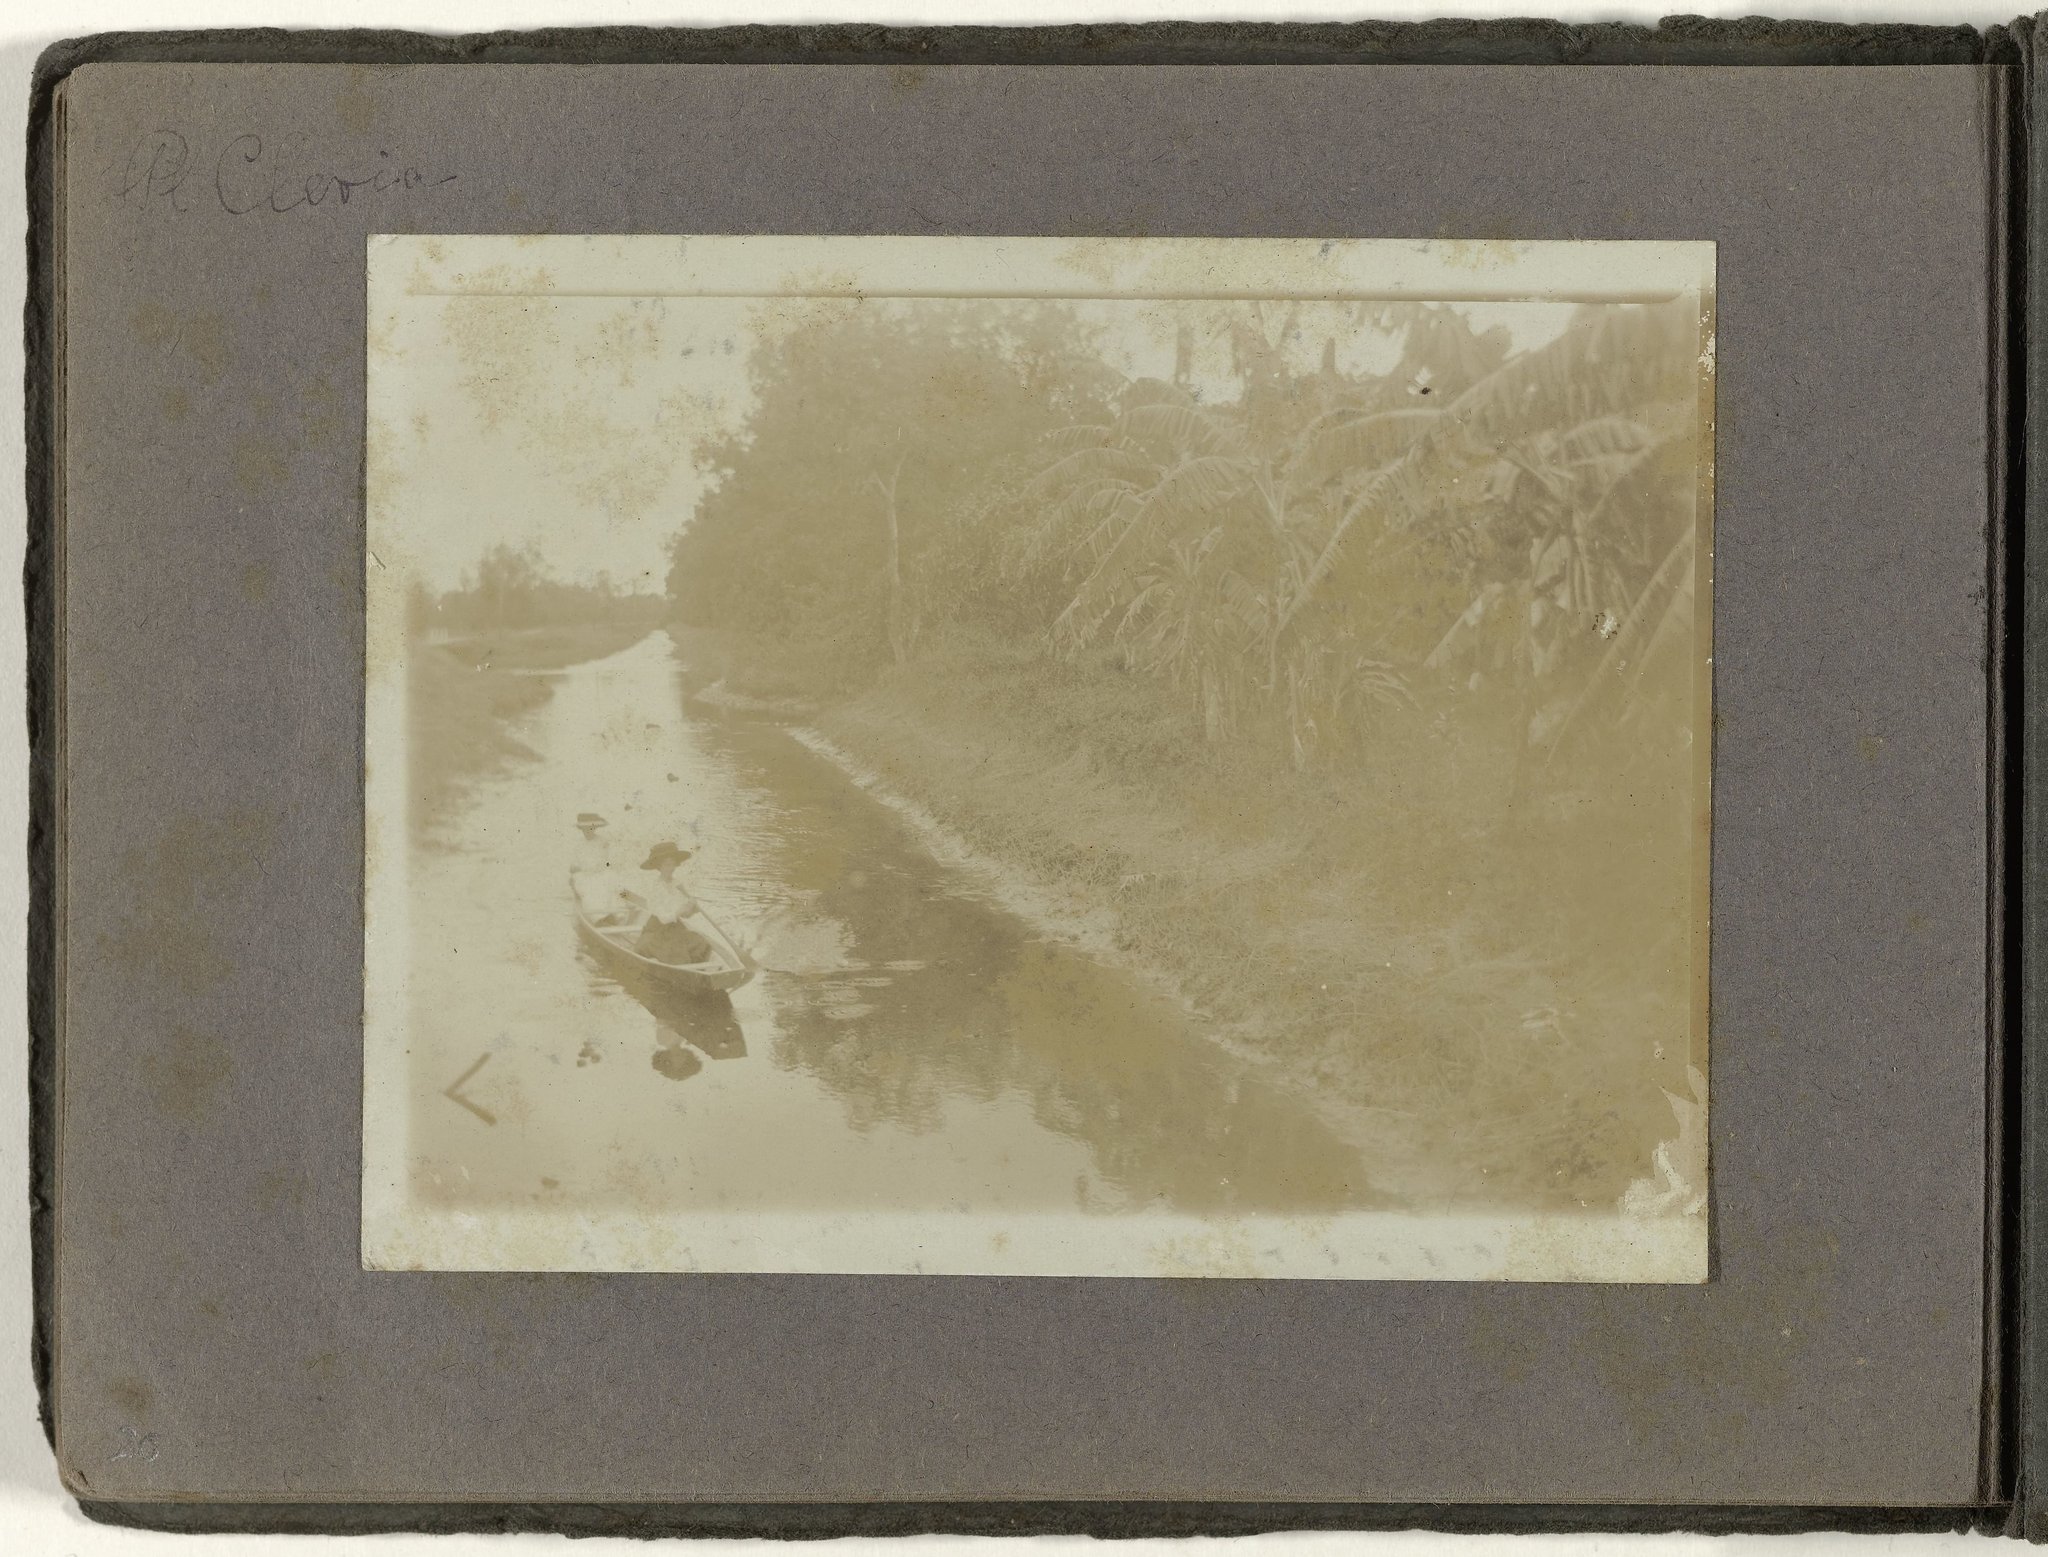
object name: photograph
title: Twee vrouwen in een kano op Clevia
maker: Anonymous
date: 1910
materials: photographic support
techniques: gelatin silver print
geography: suriname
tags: plantation, suriname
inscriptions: inscription: ‘Pl. Clevia’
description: Twee vrouwen, waaronder waarschijnlijk Maria Gonggrijp, in een kano op Plantage Clevia. Rechts bananenbomen. Onderdeel van het fotoalbum over de familie Gonggrijp op de plantages Clevia en Morgenstond in Suriname rond 1910.